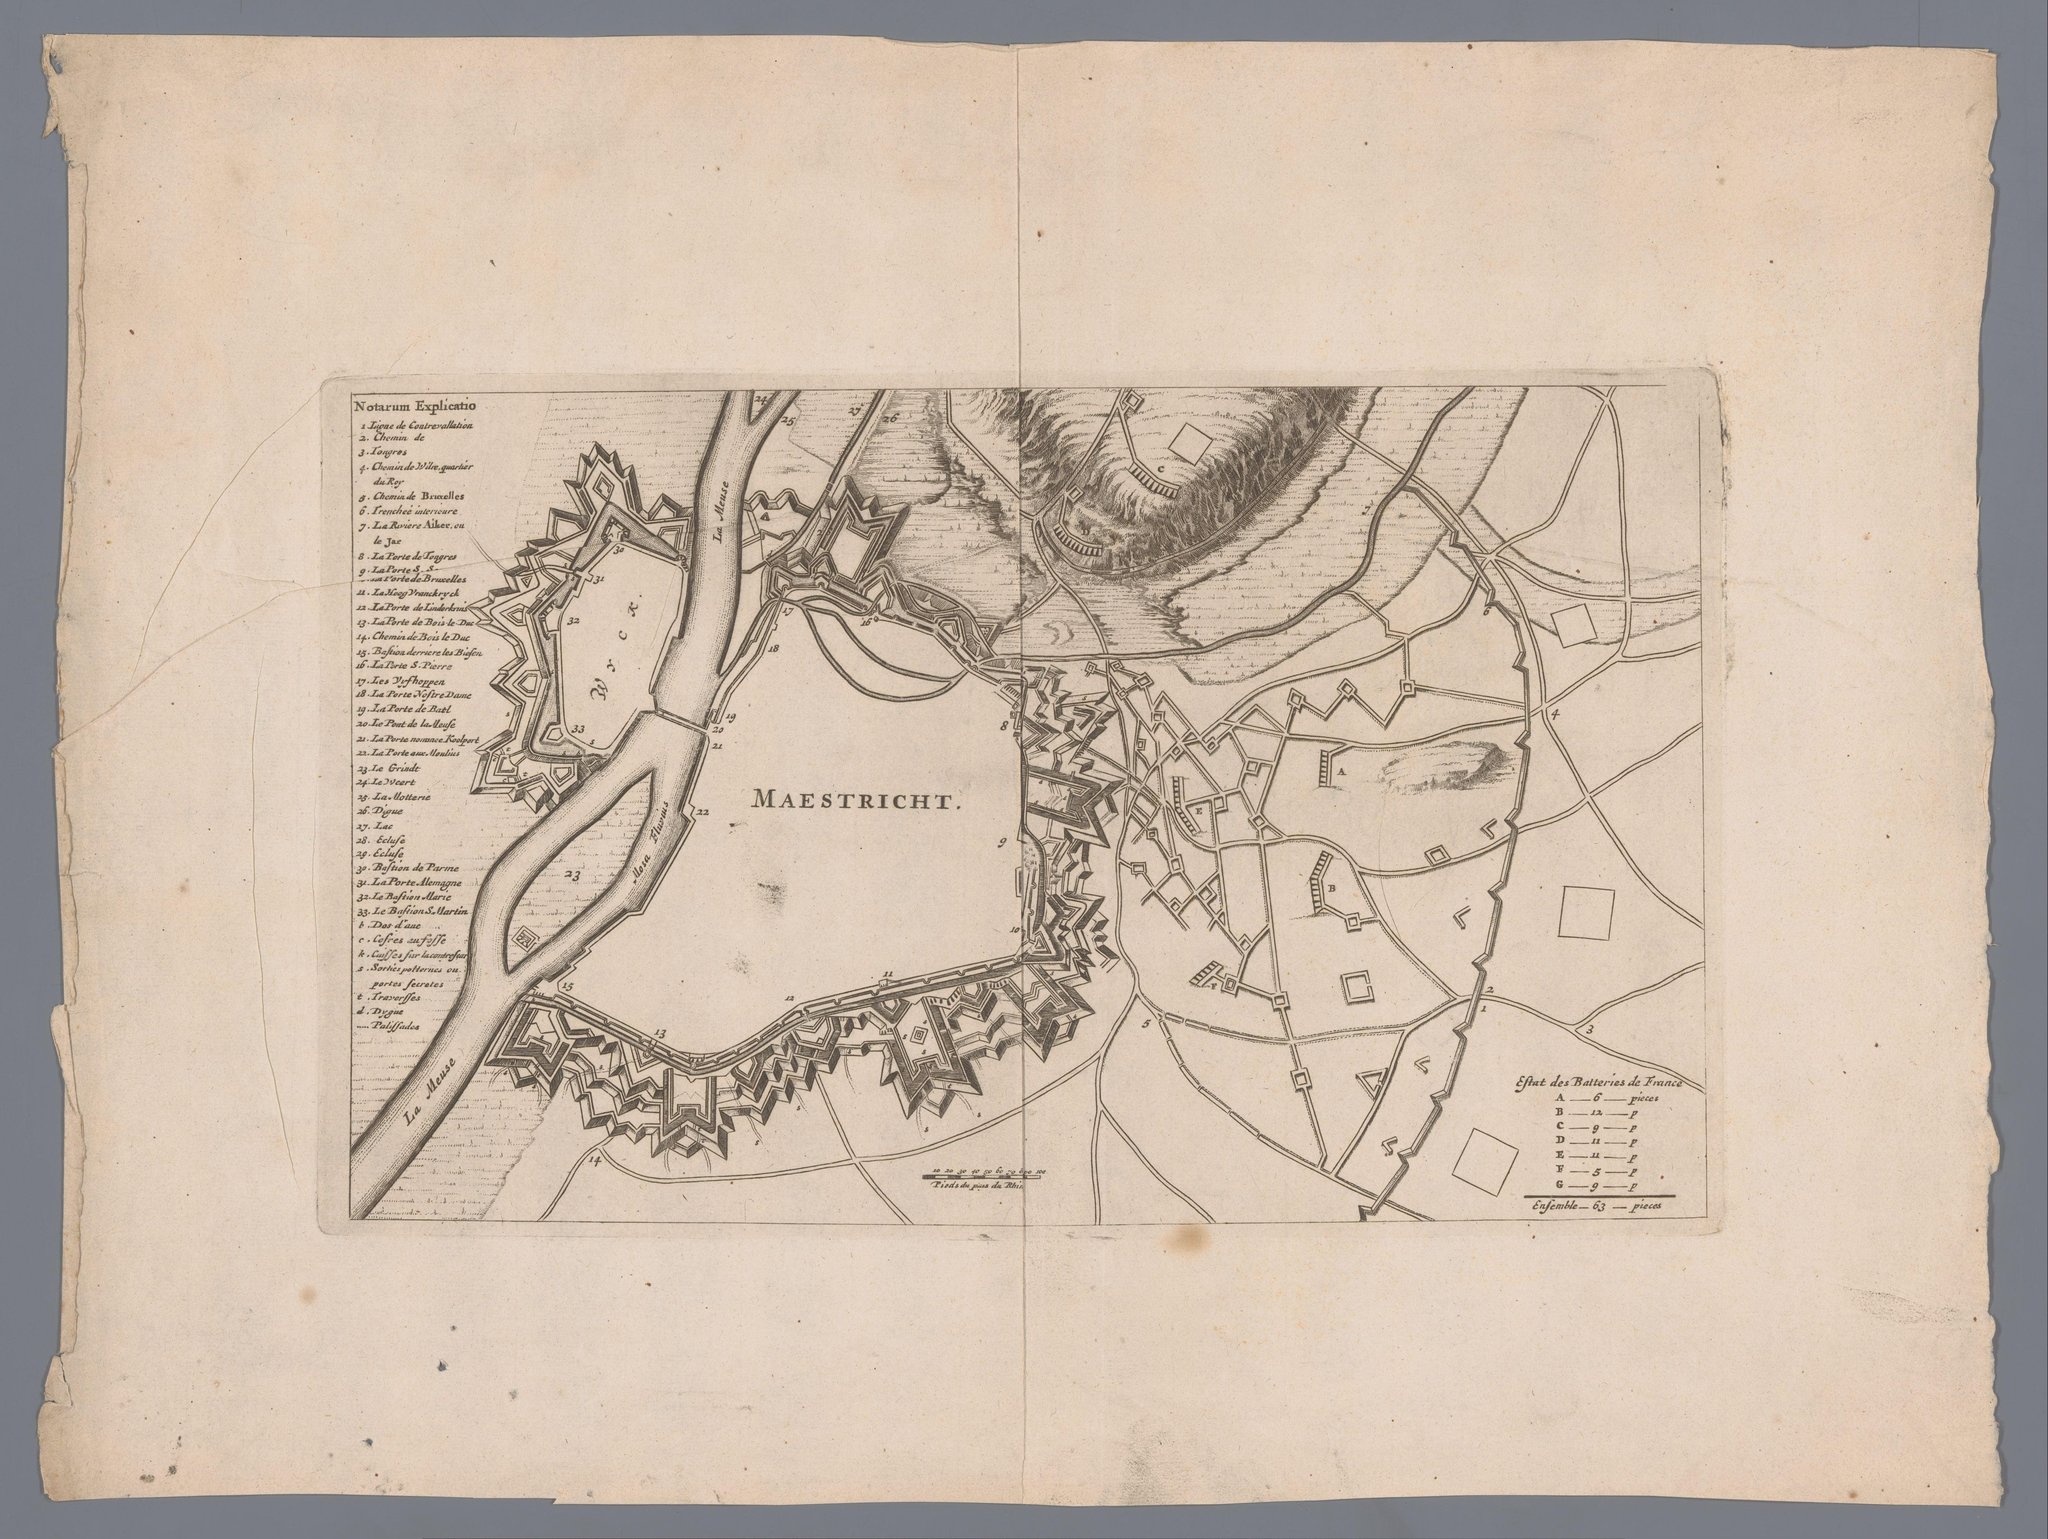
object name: area plan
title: Vestingplattegrond van Maastricht, 1673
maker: Anonymous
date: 1673-1675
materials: paper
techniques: etching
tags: fortified city, maps of cities, maastricht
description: Links een Franse legenda 1-33. Mogelijk een vestingplattegrond bij het Beleg van Maastricht door de Fransen, 1673.